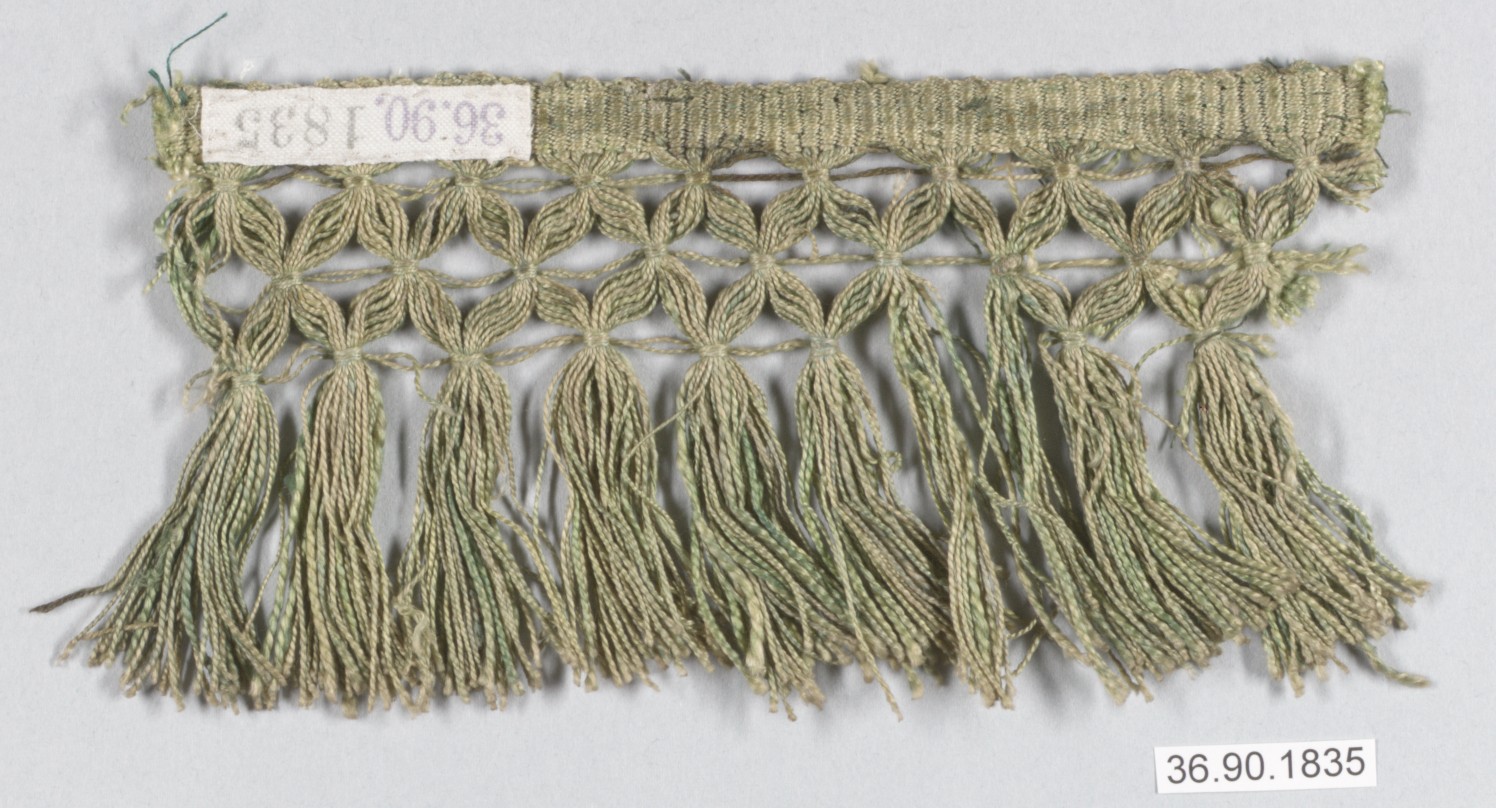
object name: fringe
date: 1867-1900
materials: silk